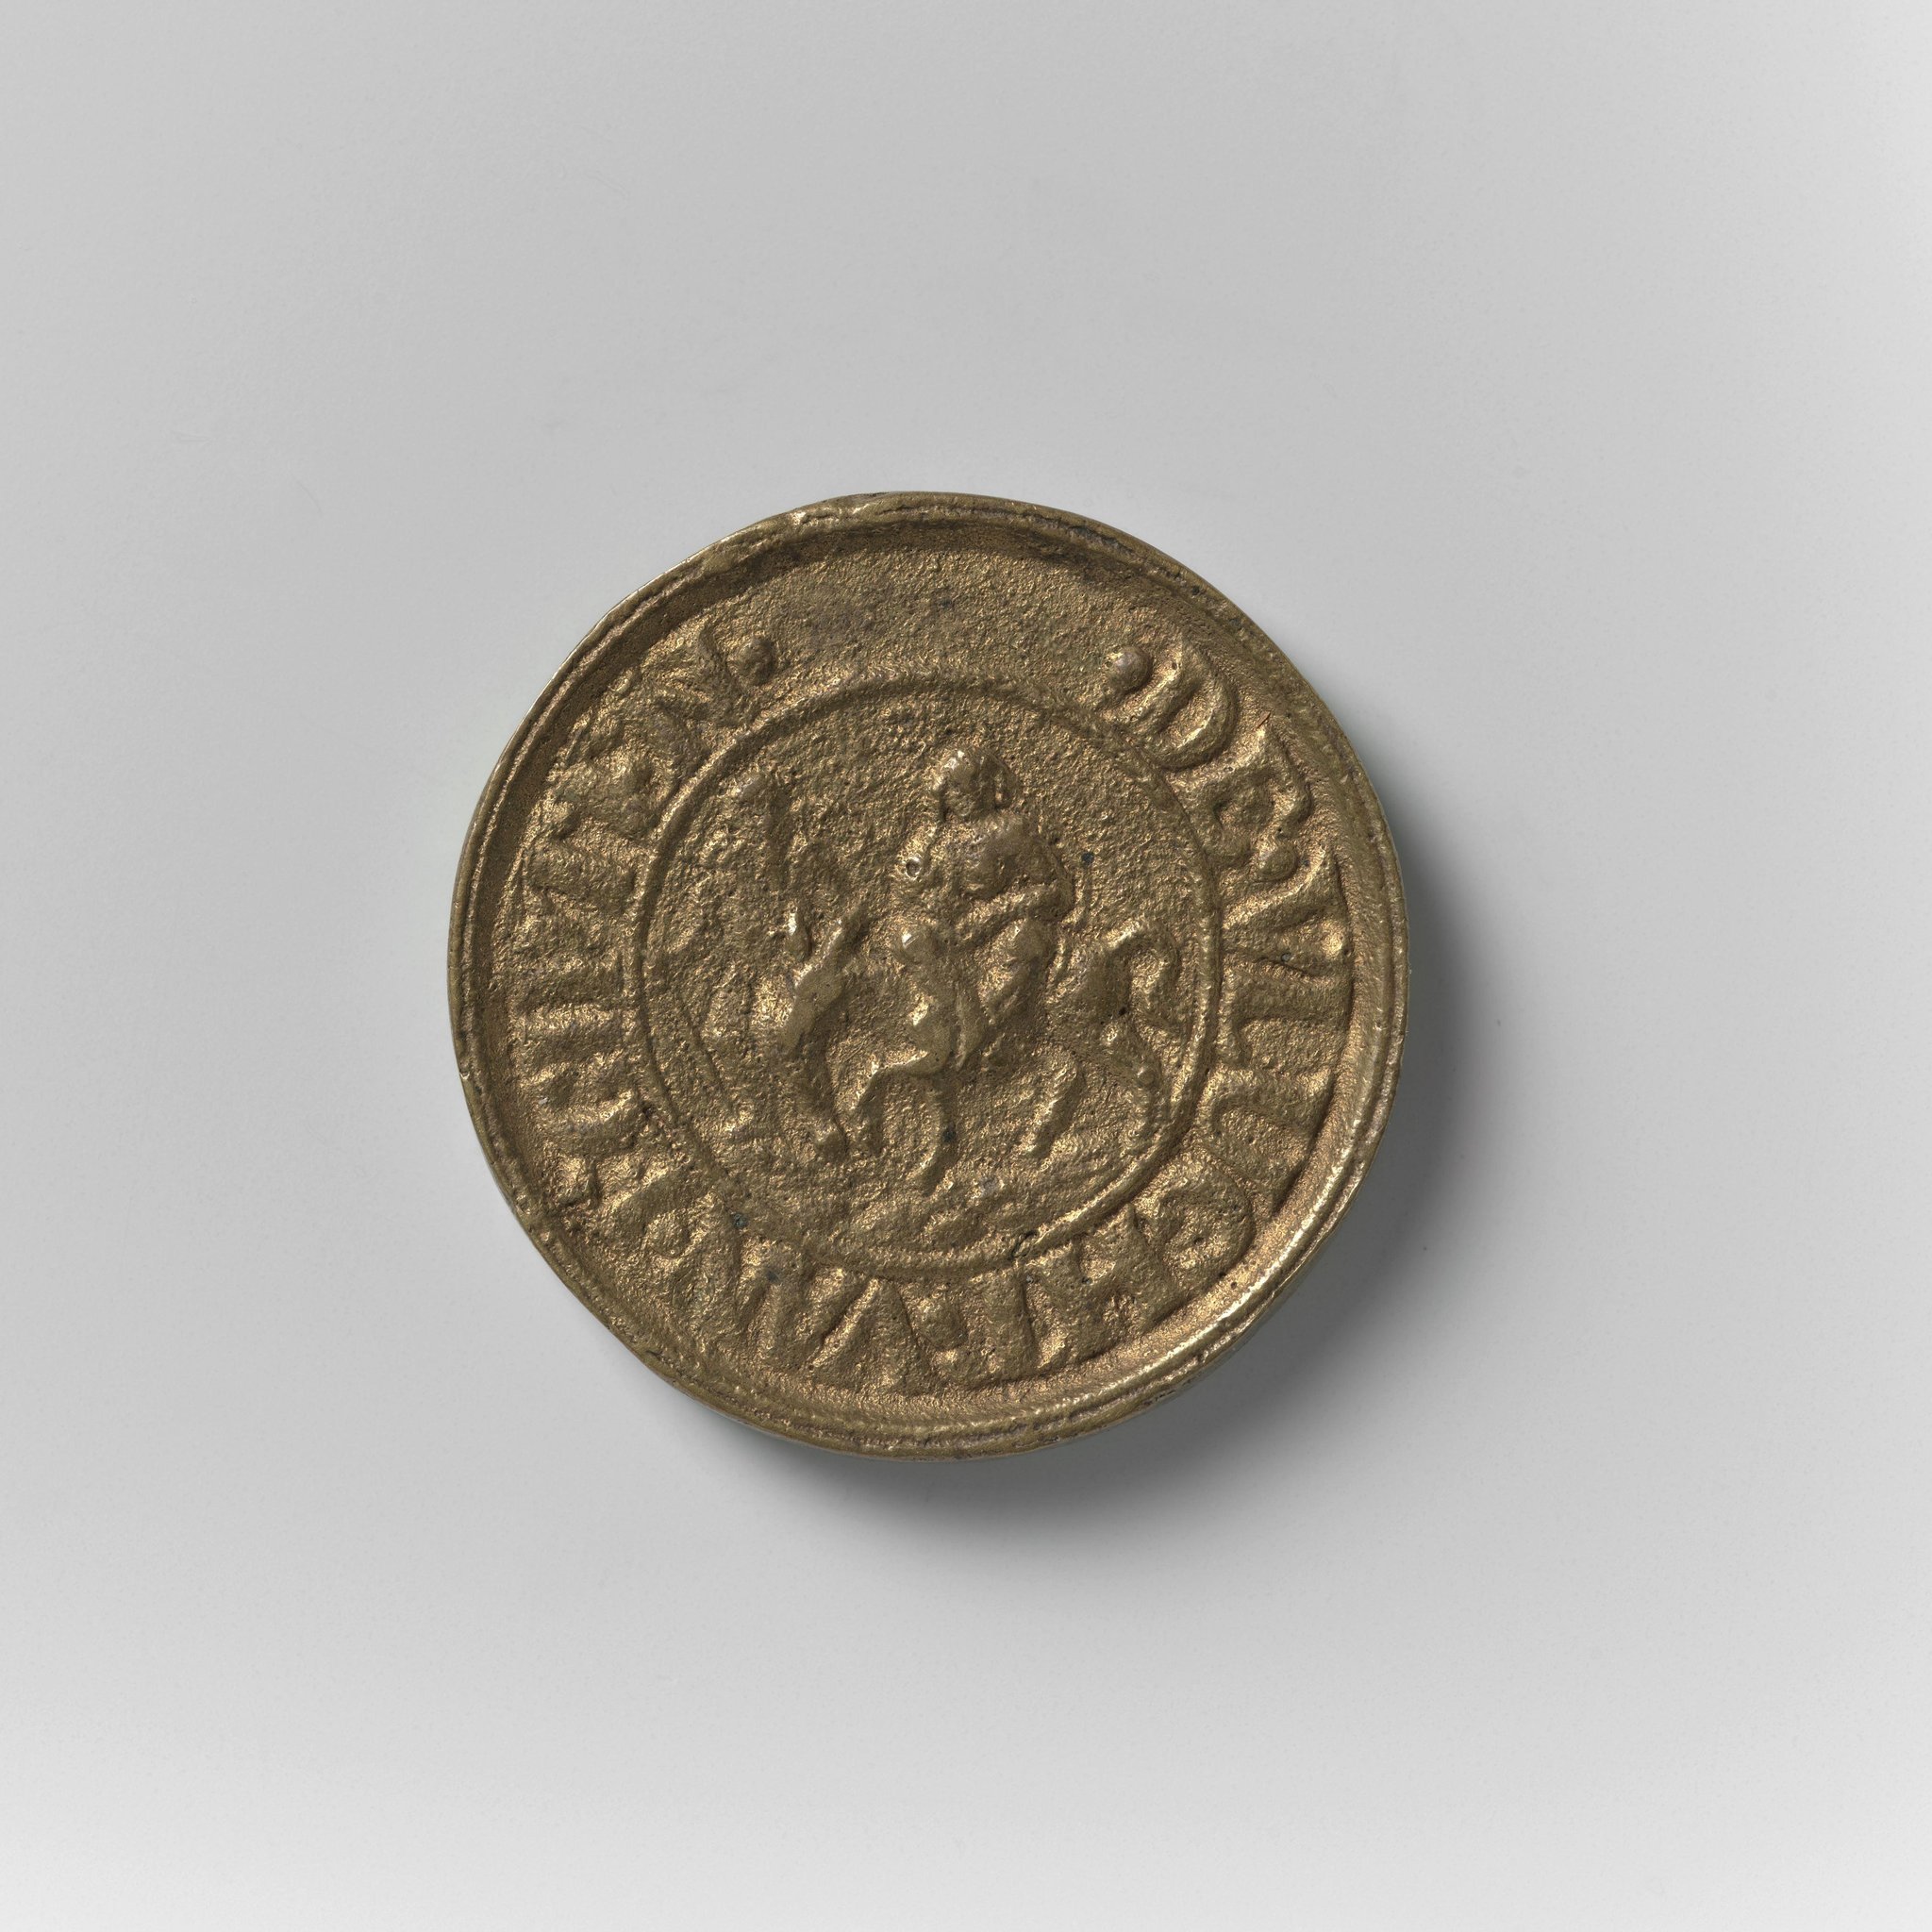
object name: history medal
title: Presentiepenning van het Sint Josephs- of Timmermansgilde te Amsterdam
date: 1796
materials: brass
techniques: casting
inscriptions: circumscription: ‘.DE.VLUGHT.VAN.EGIPTEN.’, inscription: ‘Ian Peeters / 1796’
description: Gegoten messing penning met op de voorzijde Jozef met stok en Maria met Jezus op ezel naar links, met omschrift, op de keerzijde een gekroond wapenschild Amsterdam met dragers boven een inscriptieruimte, op naam van Jan Peeters 1796